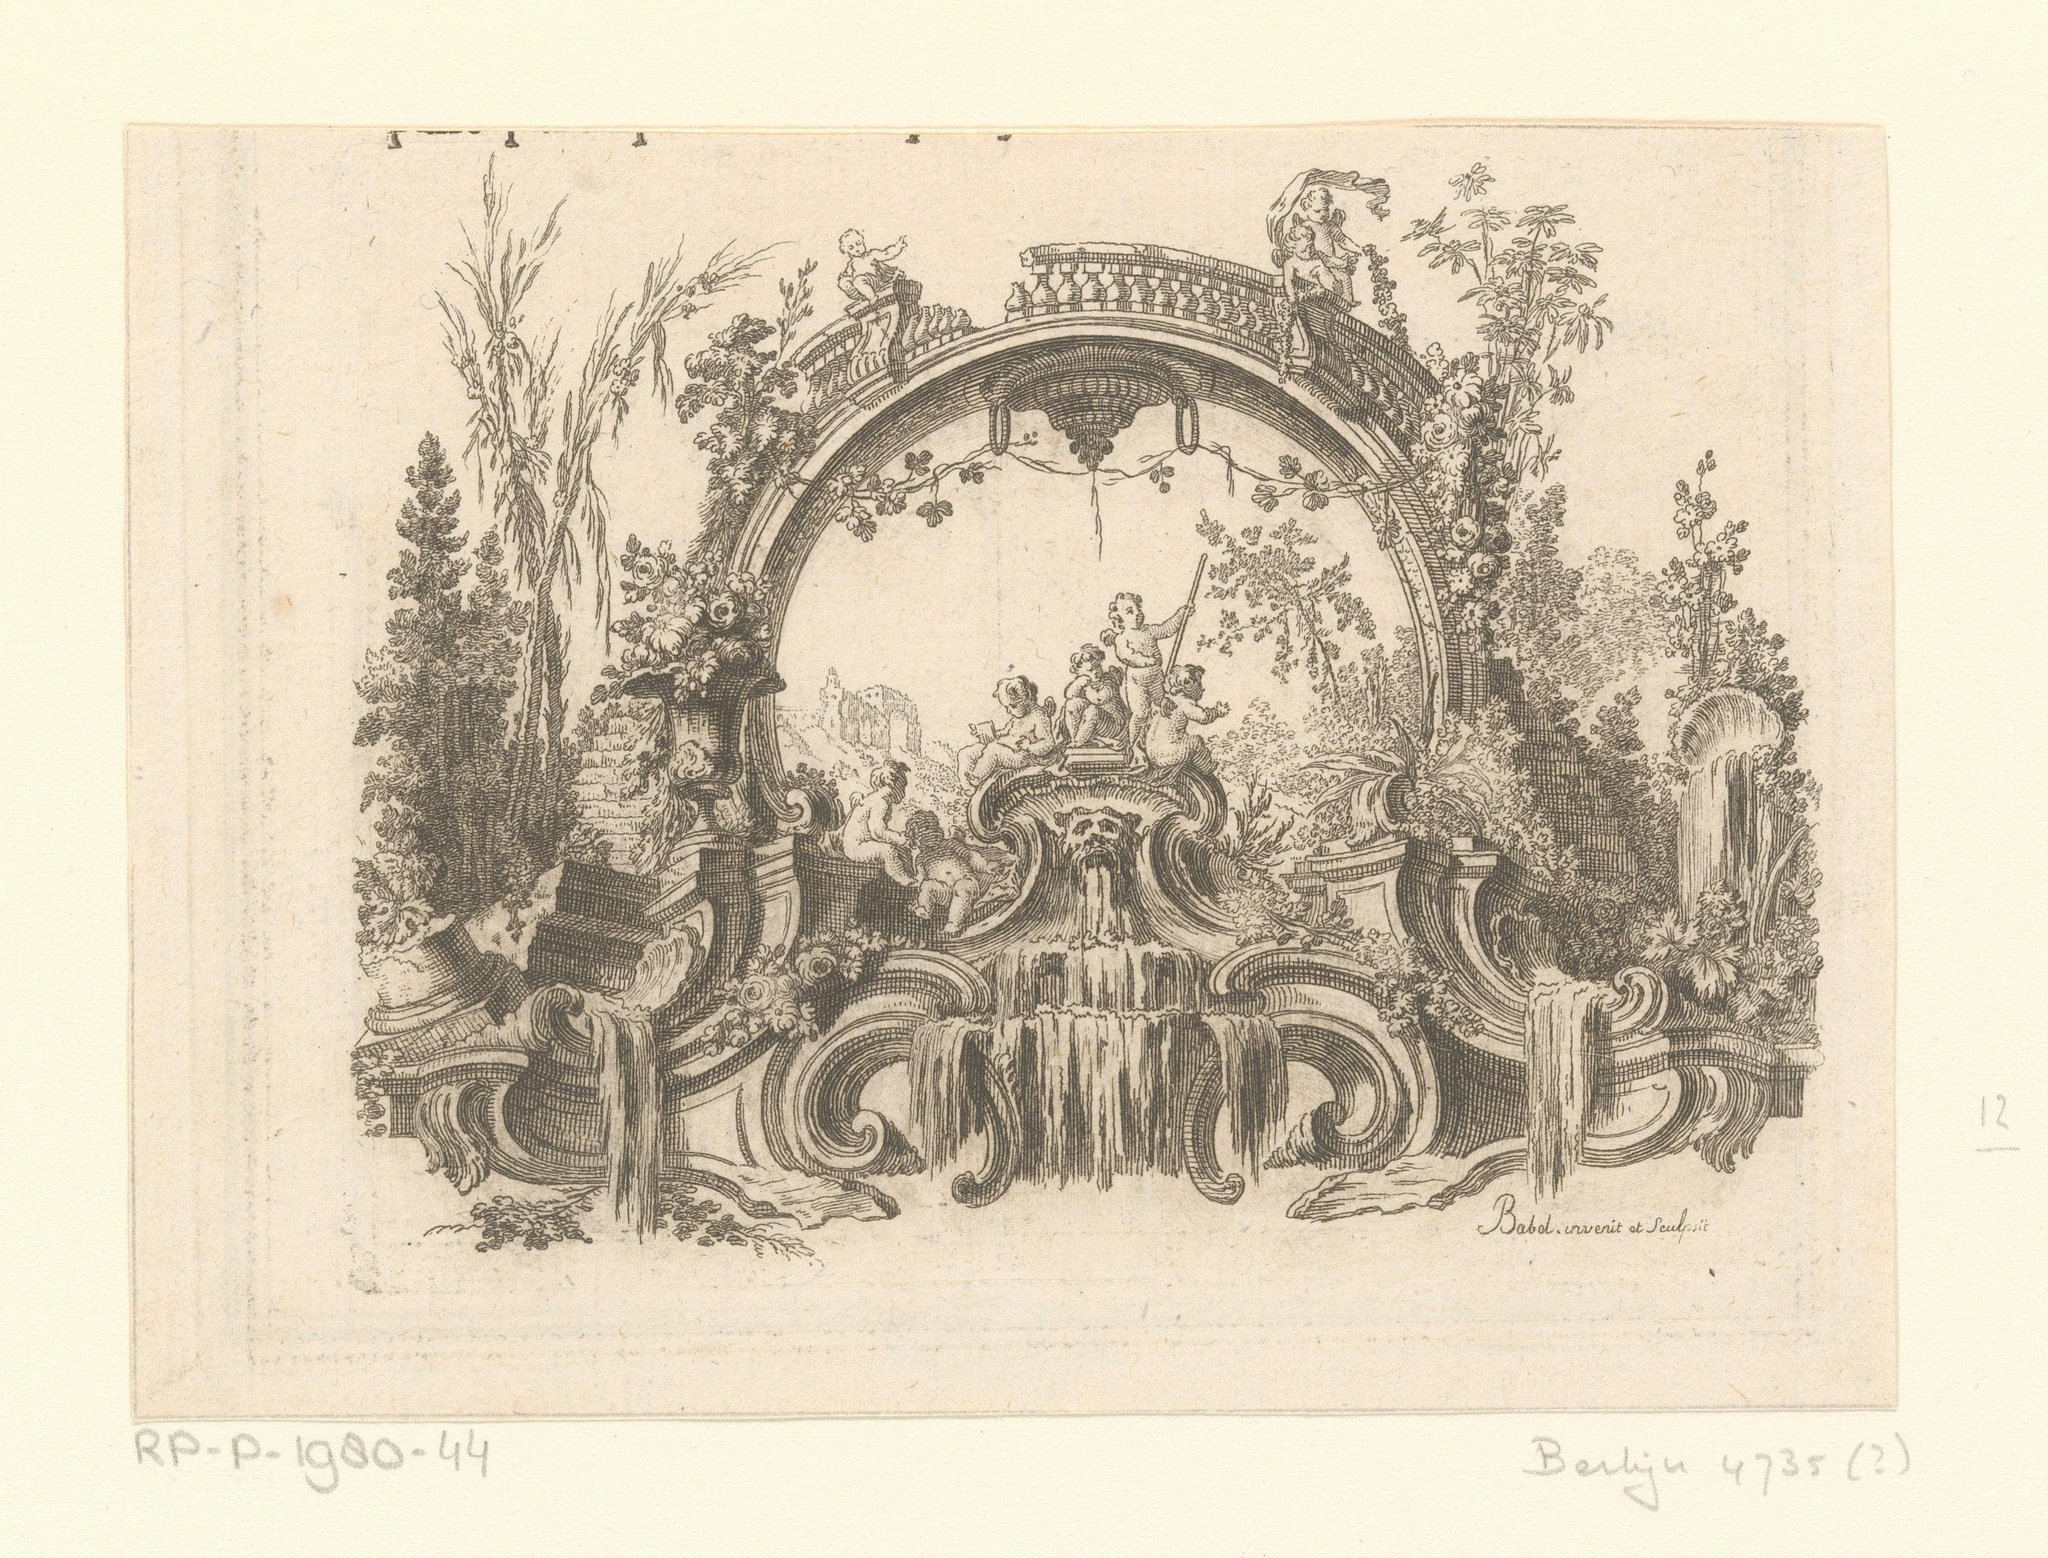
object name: ornament print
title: Vignet met putti op een fontein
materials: paper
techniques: etching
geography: paris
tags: garden fountain, cupids: 'amores', 'amoretti', 'putti'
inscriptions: collector's mark: Lugt 2228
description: Pagina 12 uit: Edme-Sébastien. Traité de perspective à l'usage des artistes (...). Parijs: Jombert, Charles Antoine, 1750.